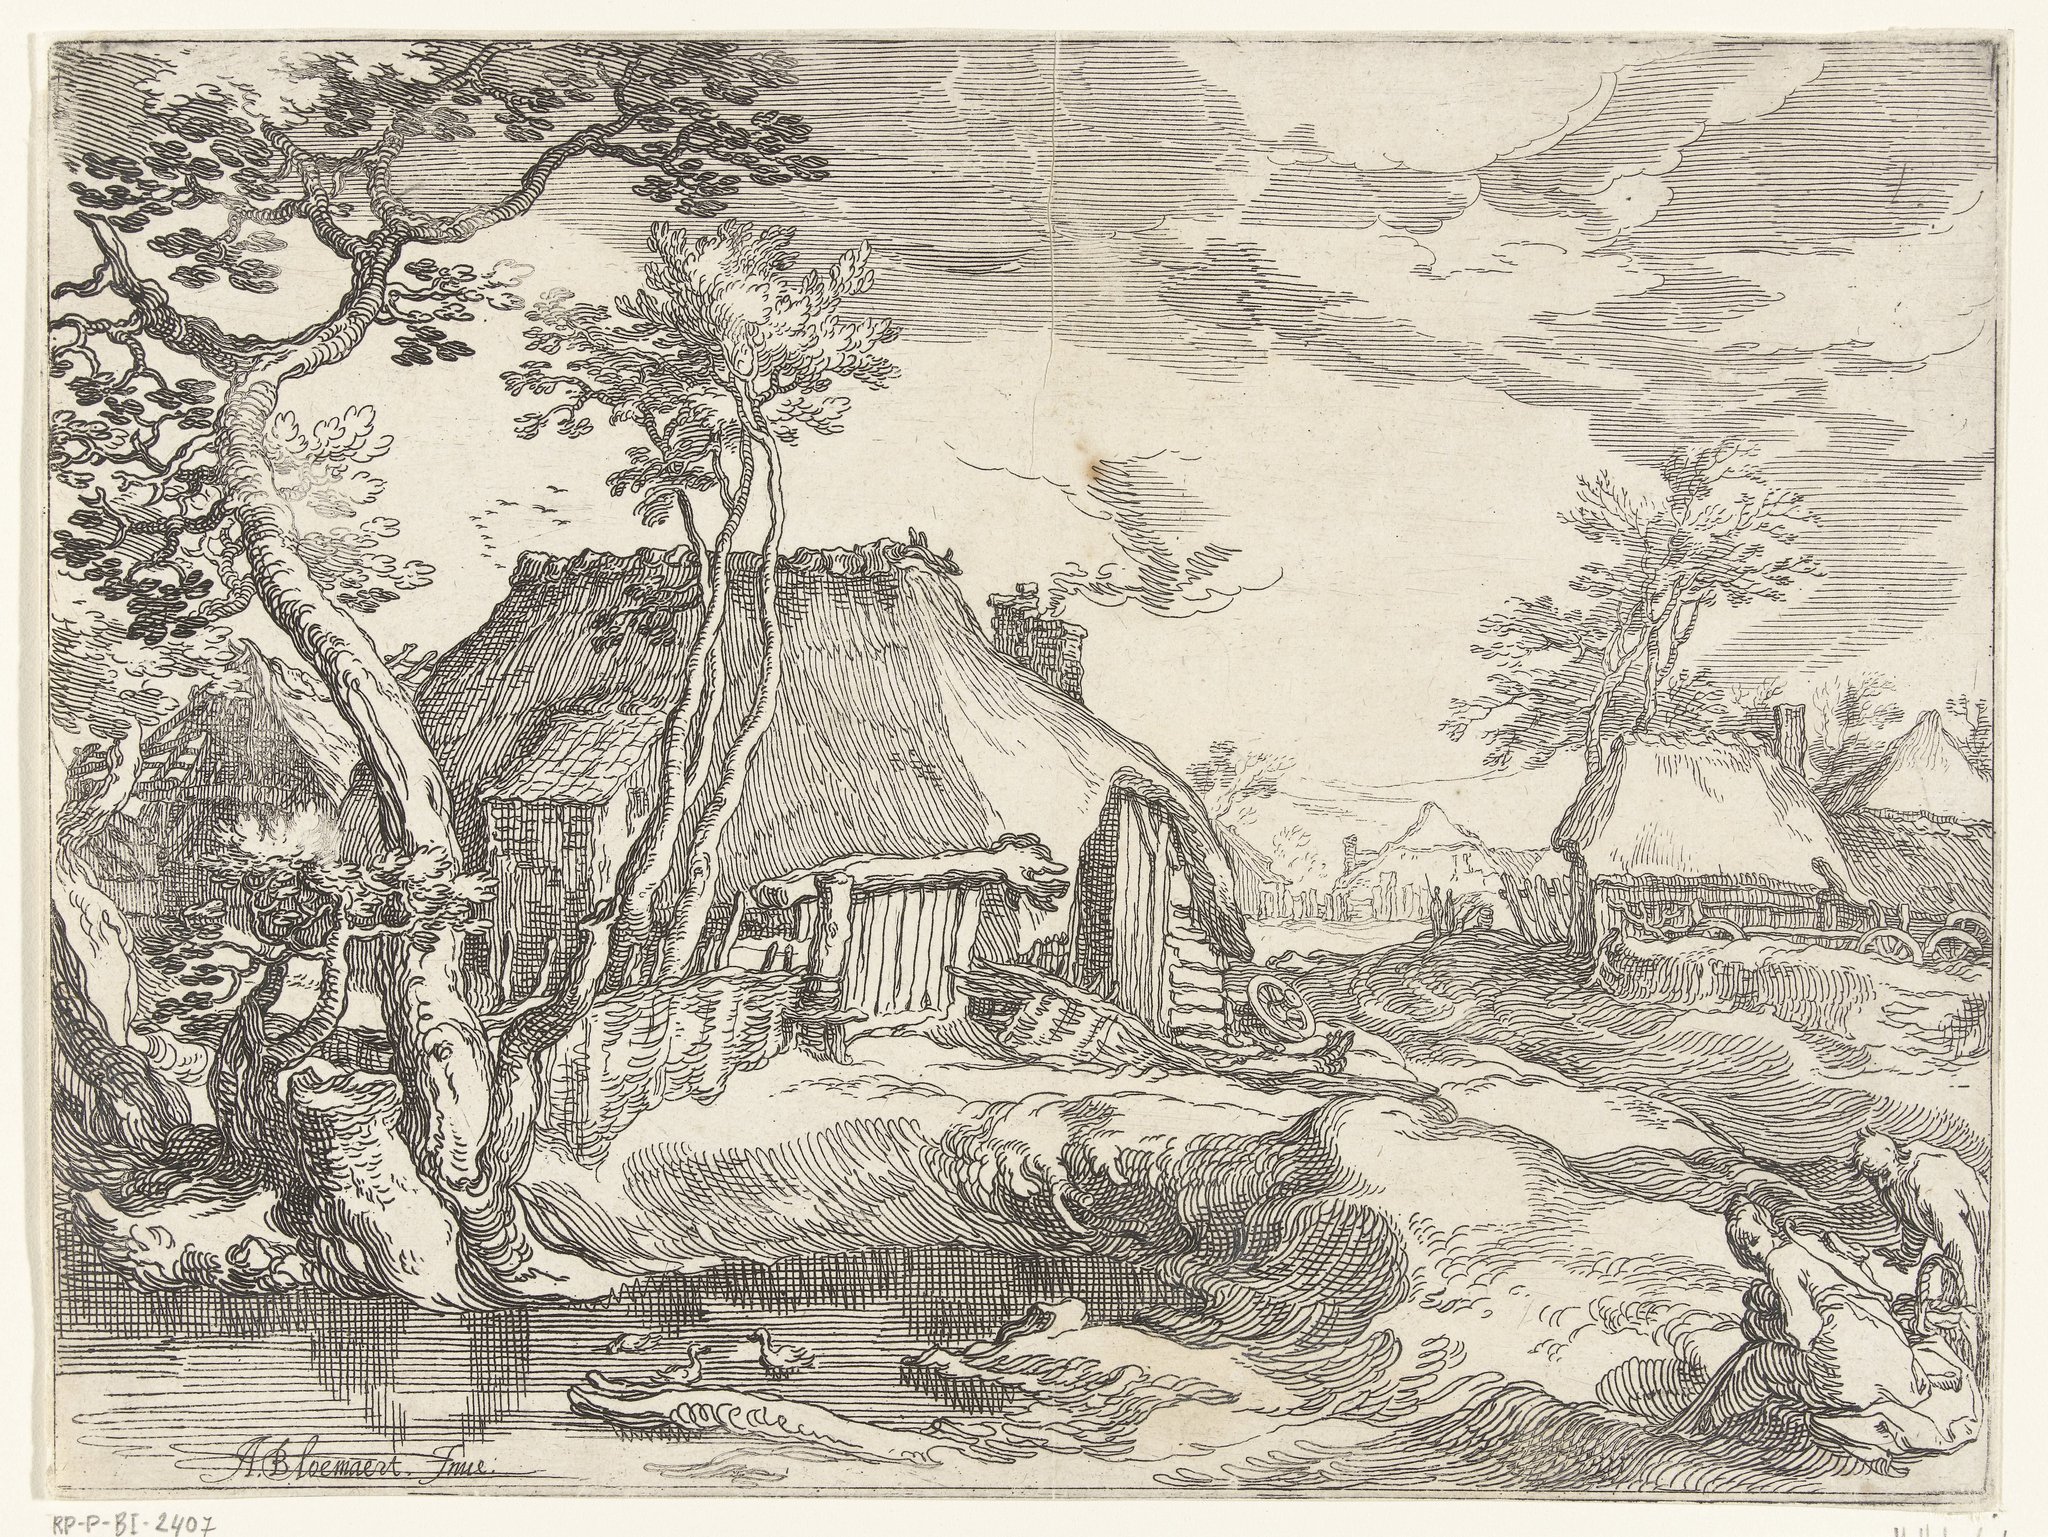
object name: print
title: Landschap met boerderijen aan landweg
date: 1612-1614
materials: paper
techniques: etching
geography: amsterdam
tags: farm or solitary house in landscape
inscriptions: collector's mark: Lugt 240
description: Prent uit serie van vier Gezichten op het platteland naar ontwerp van Abraham Bloemaert.